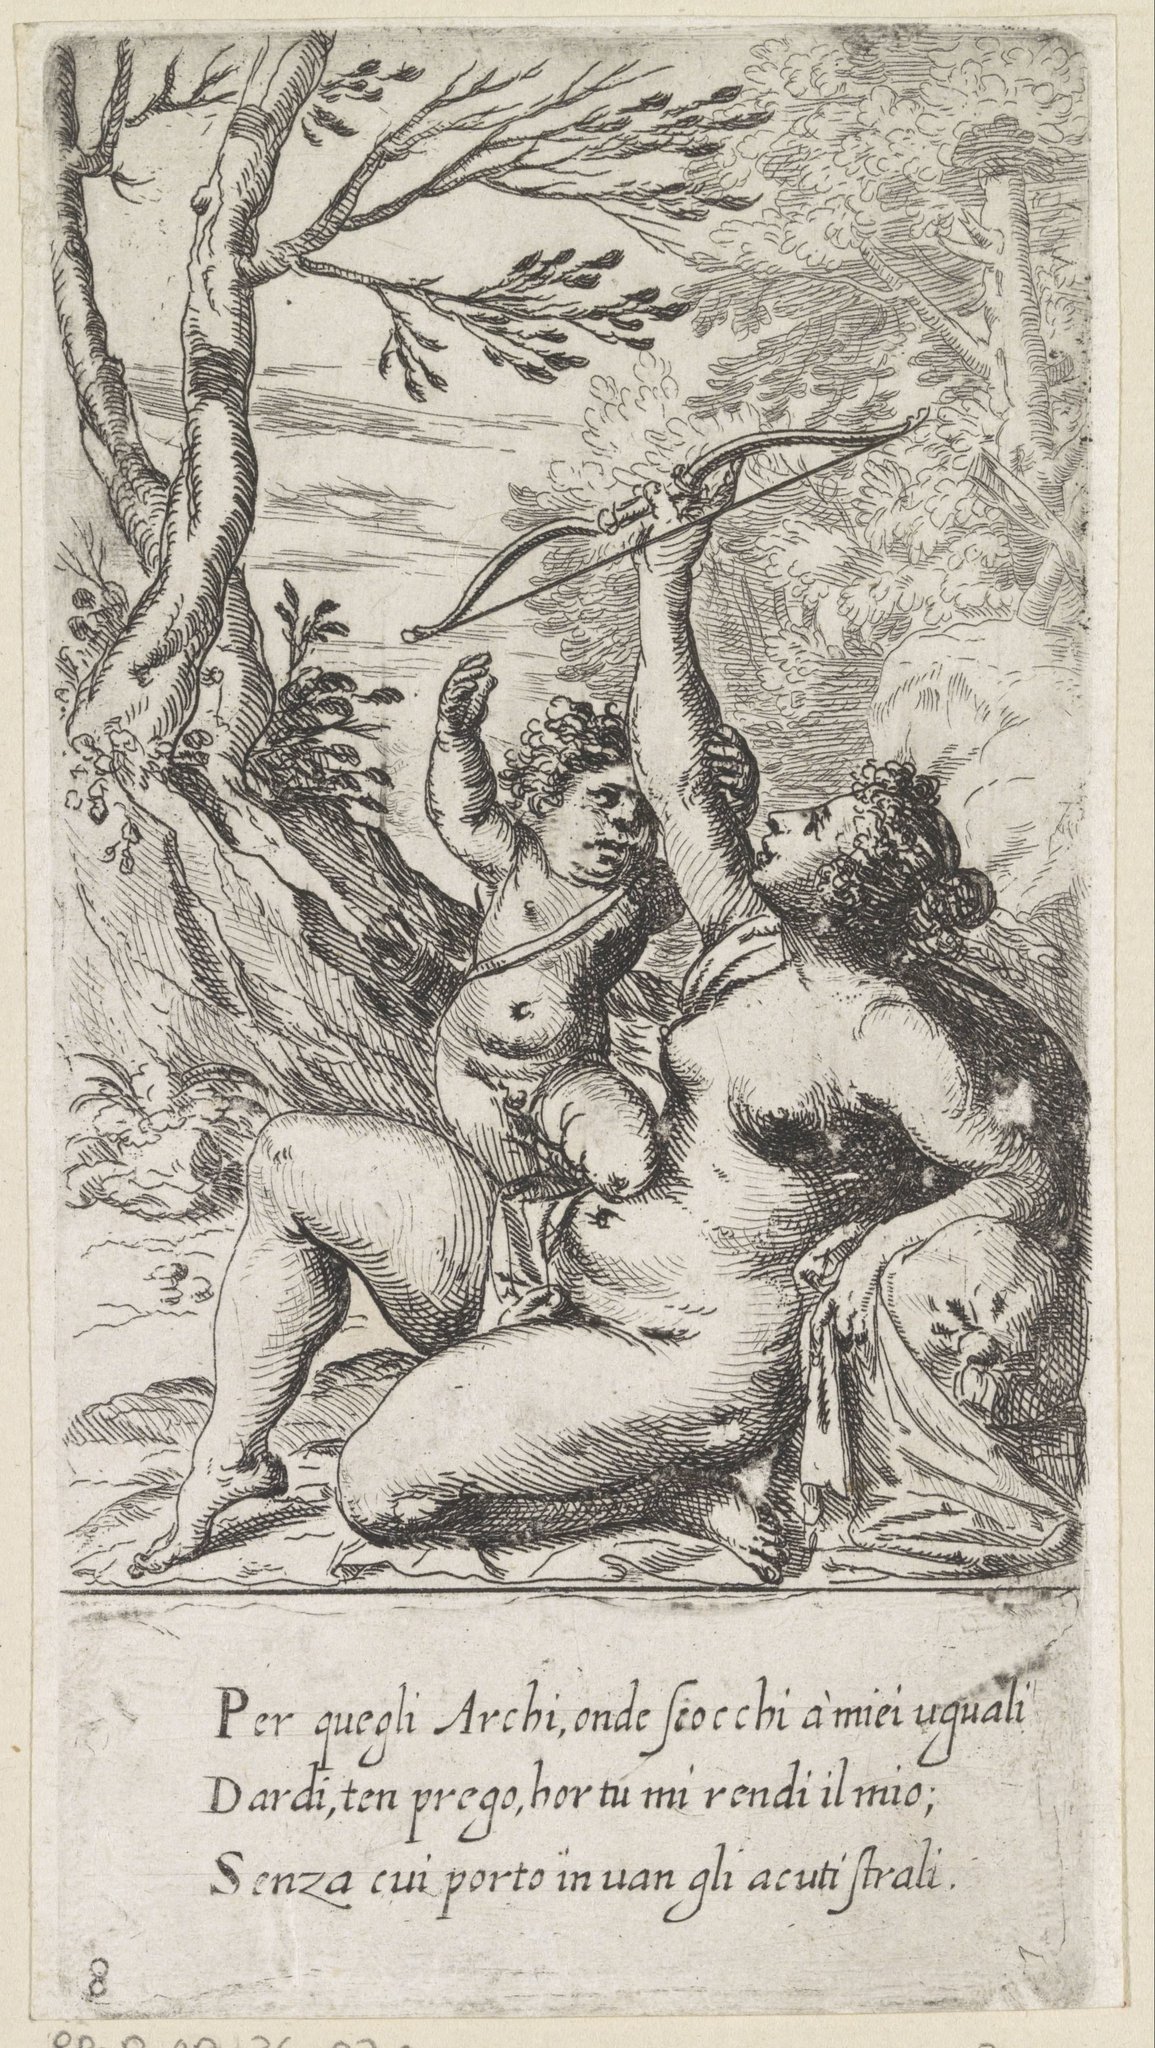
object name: print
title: Scherzi d'amore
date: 1617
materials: paper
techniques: etching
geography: venice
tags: venus and cupid (cupid not being mere attribute)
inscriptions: collector's mark: Lugt 240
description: Prent uit een reeks van 13 prenten (Bartsch 7-19). Alleen de eerste 10 prenten zijn genummerd (2-11), plus de tweede titelpagina (1) (Bartsch 6). De serie heeft twee titelpagina's (Bartsch 5 & 6).